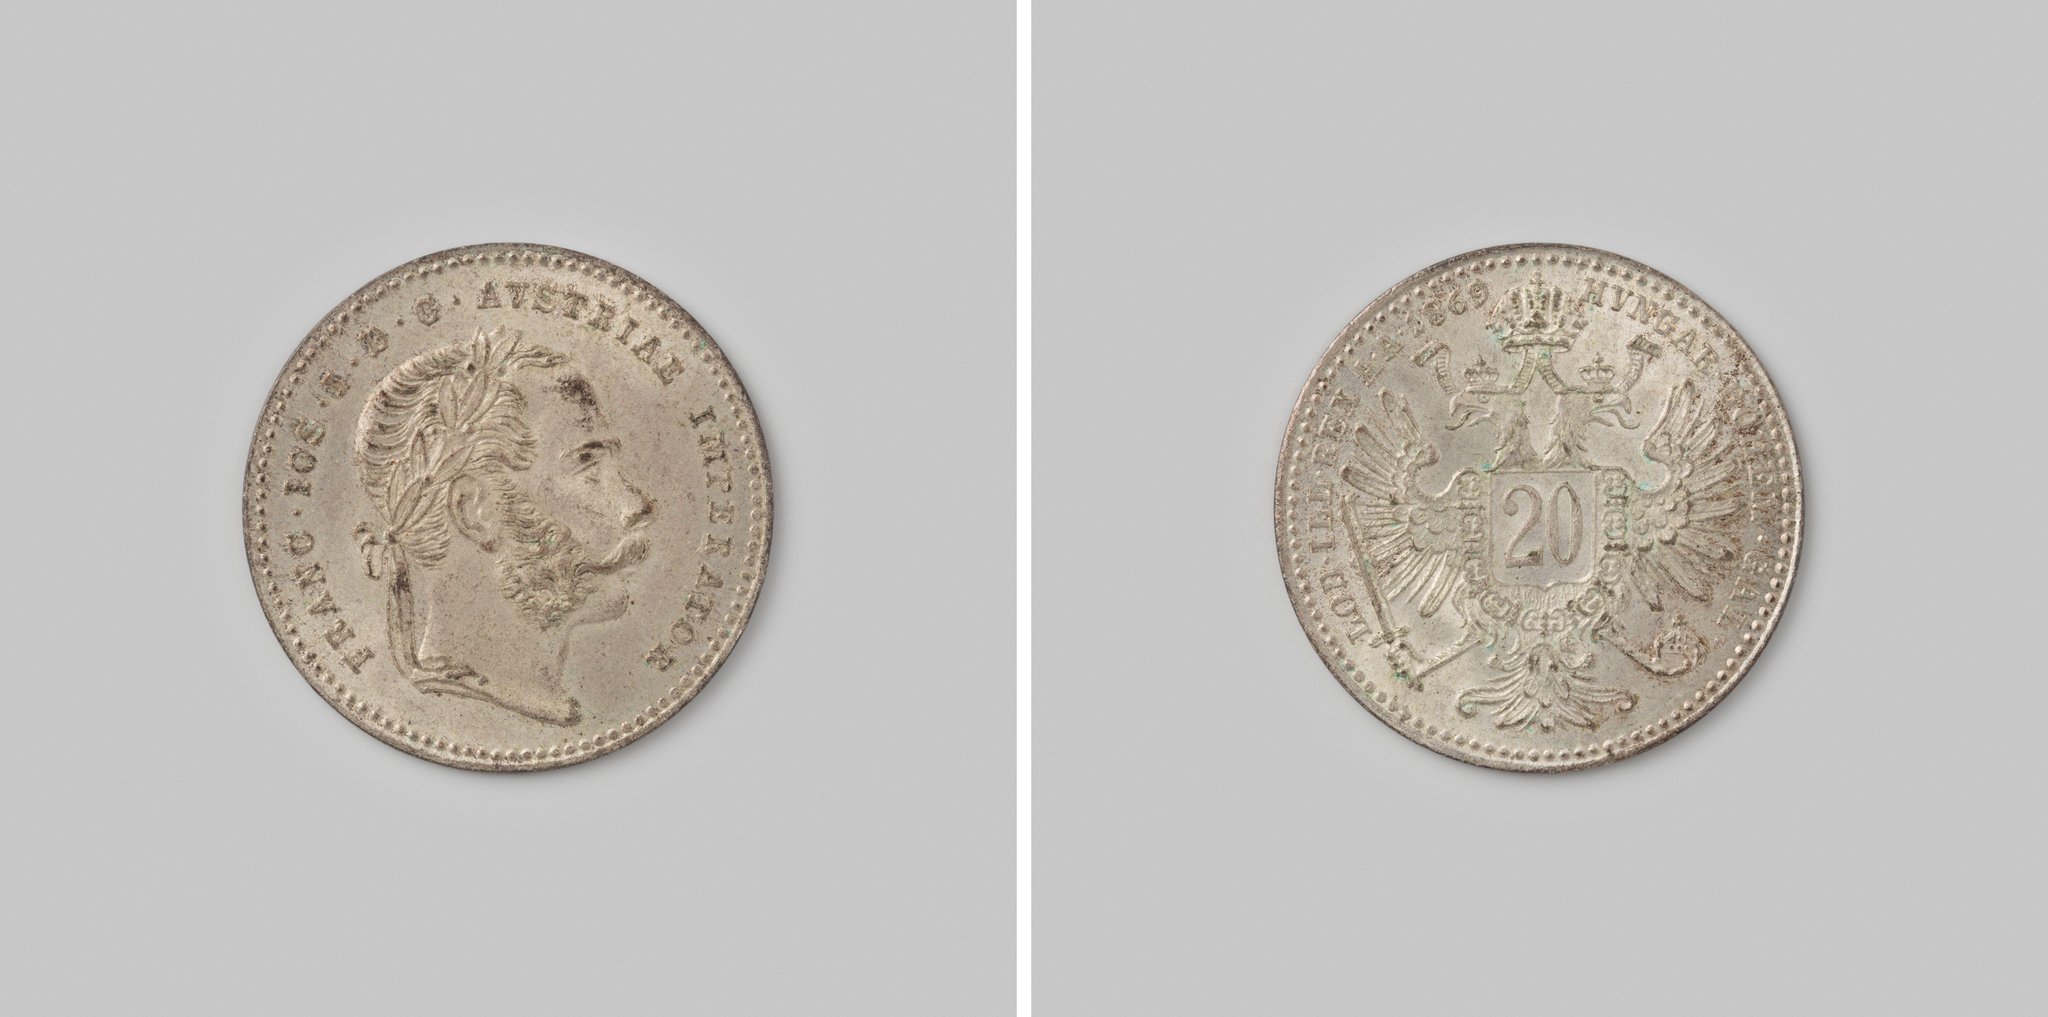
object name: coin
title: 20 Kreuzer uit het keizerrijk Oostenrijk van Franz Joseph, 1869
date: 1869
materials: silver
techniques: striking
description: Zilveren munt. Voorzijde: gelauwerd hoofd van de keizer naar rechts. Keerzijde: gekroonde dubbelkoppige adelaar met op de koppen kleine kronen. Op zijn borst door ridderorde omhangen schild, waarin waarde-aanduiding en in zijn poten een zwaard en een rijksappel. Jaartal aan het eind van het omschrift. Gladde rand.